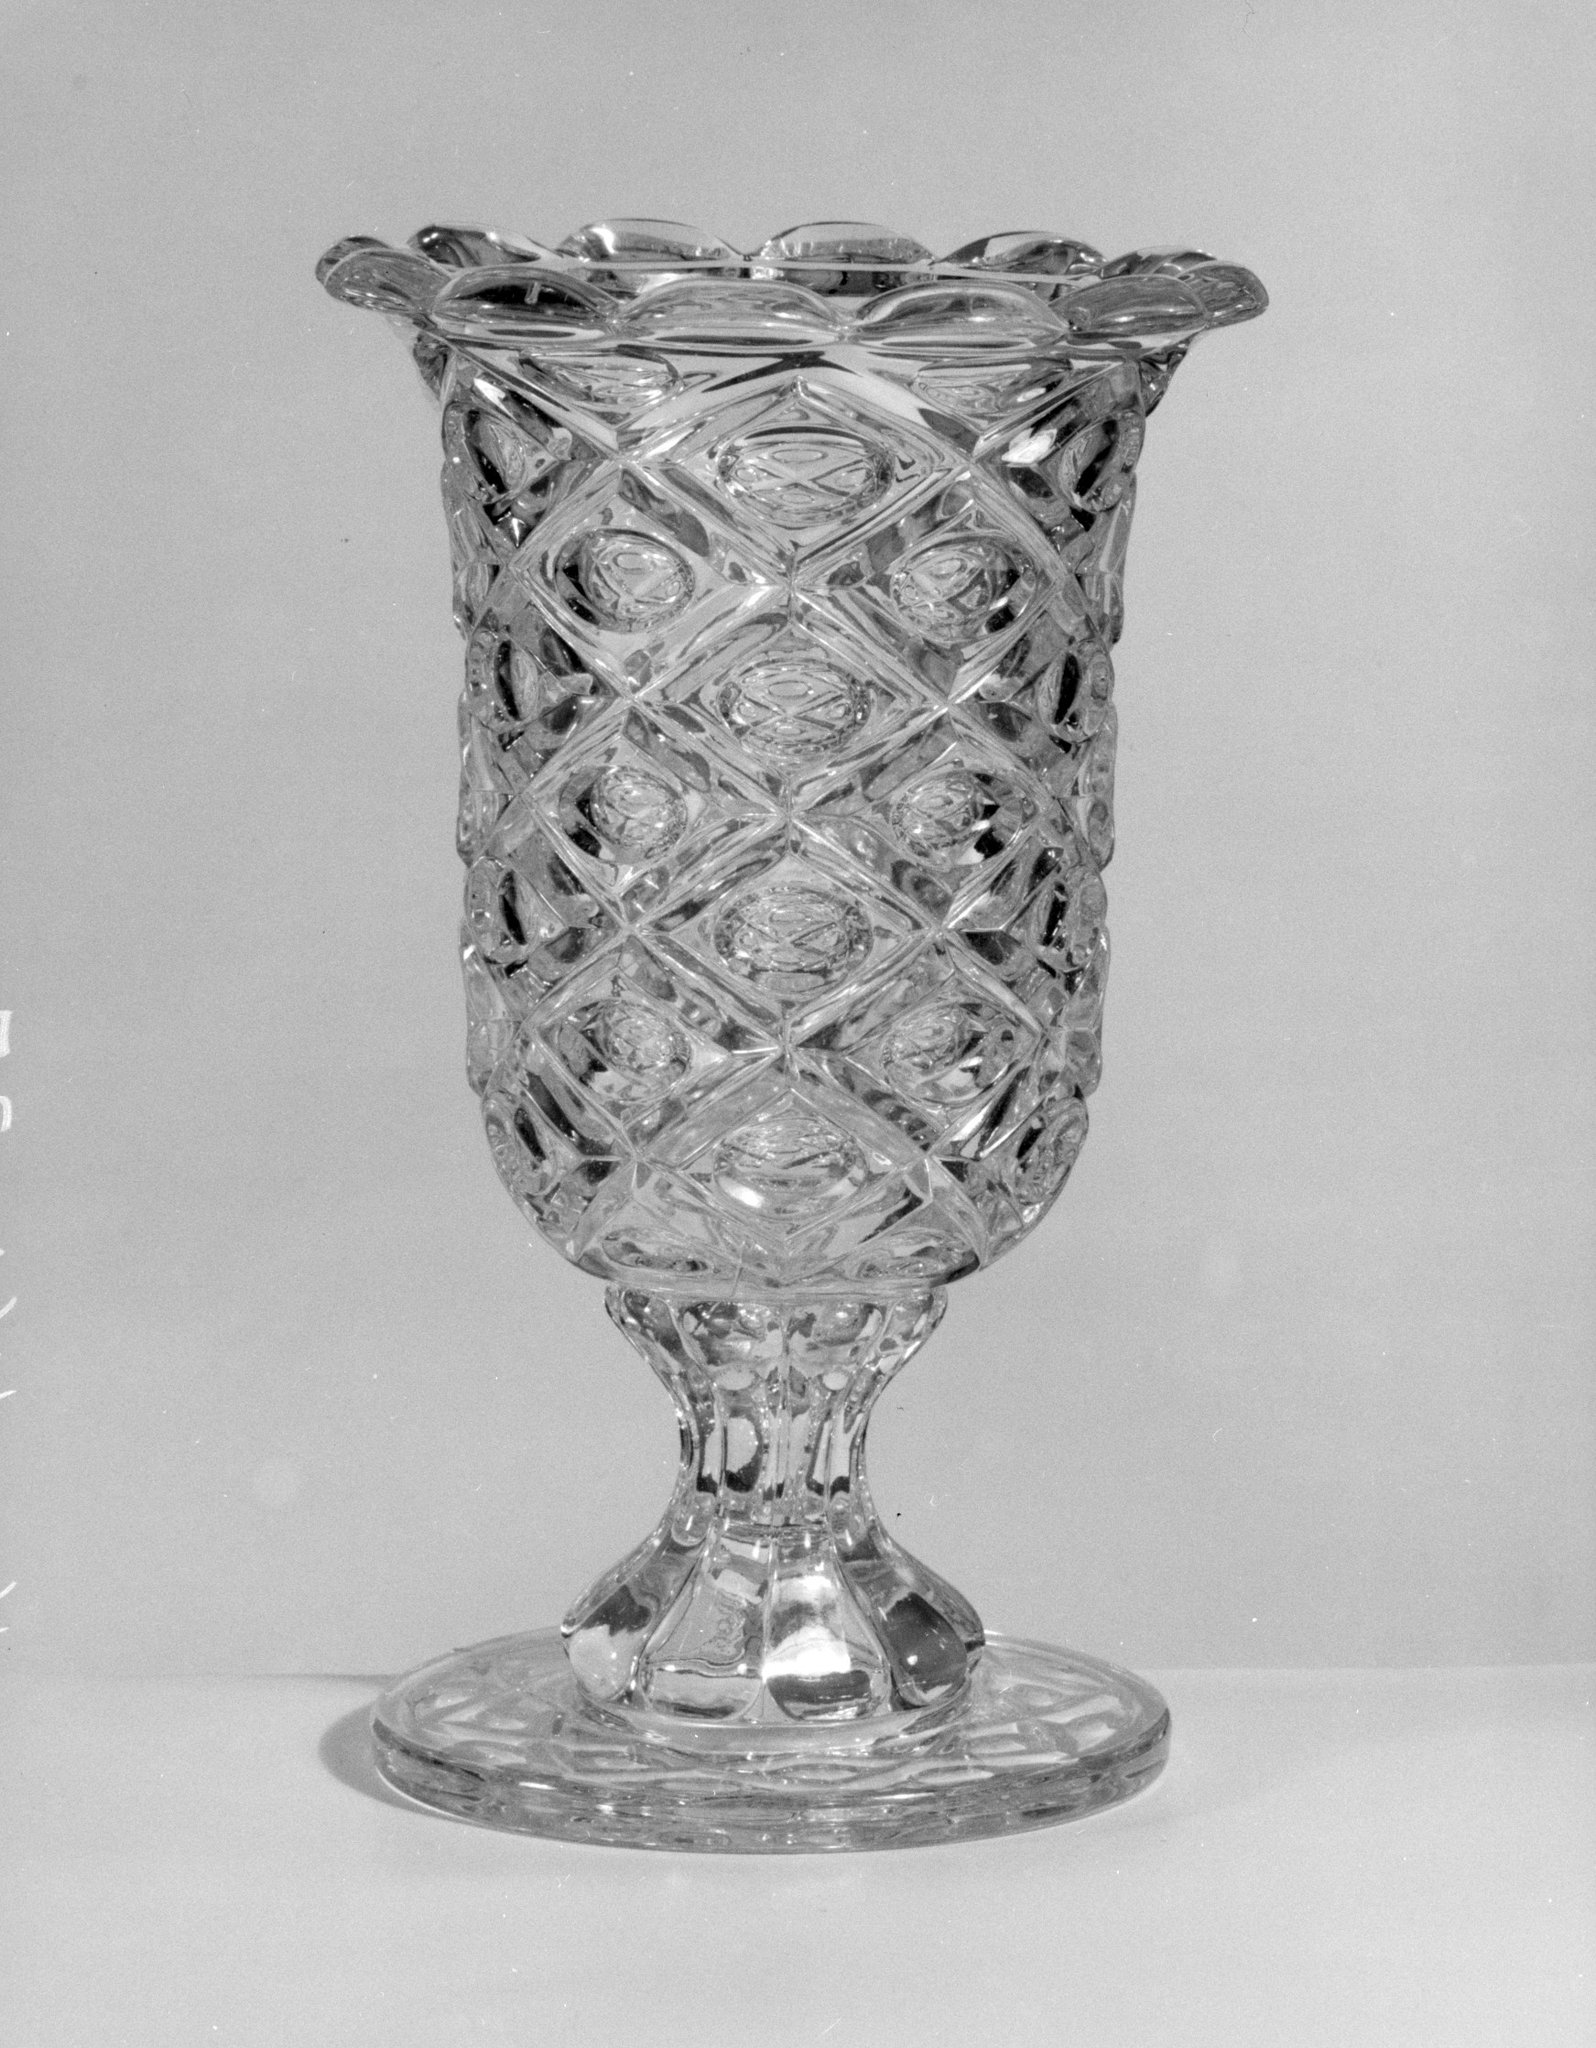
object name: celery vase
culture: american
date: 1850-1870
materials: diamond, glass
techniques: pressed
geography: united states